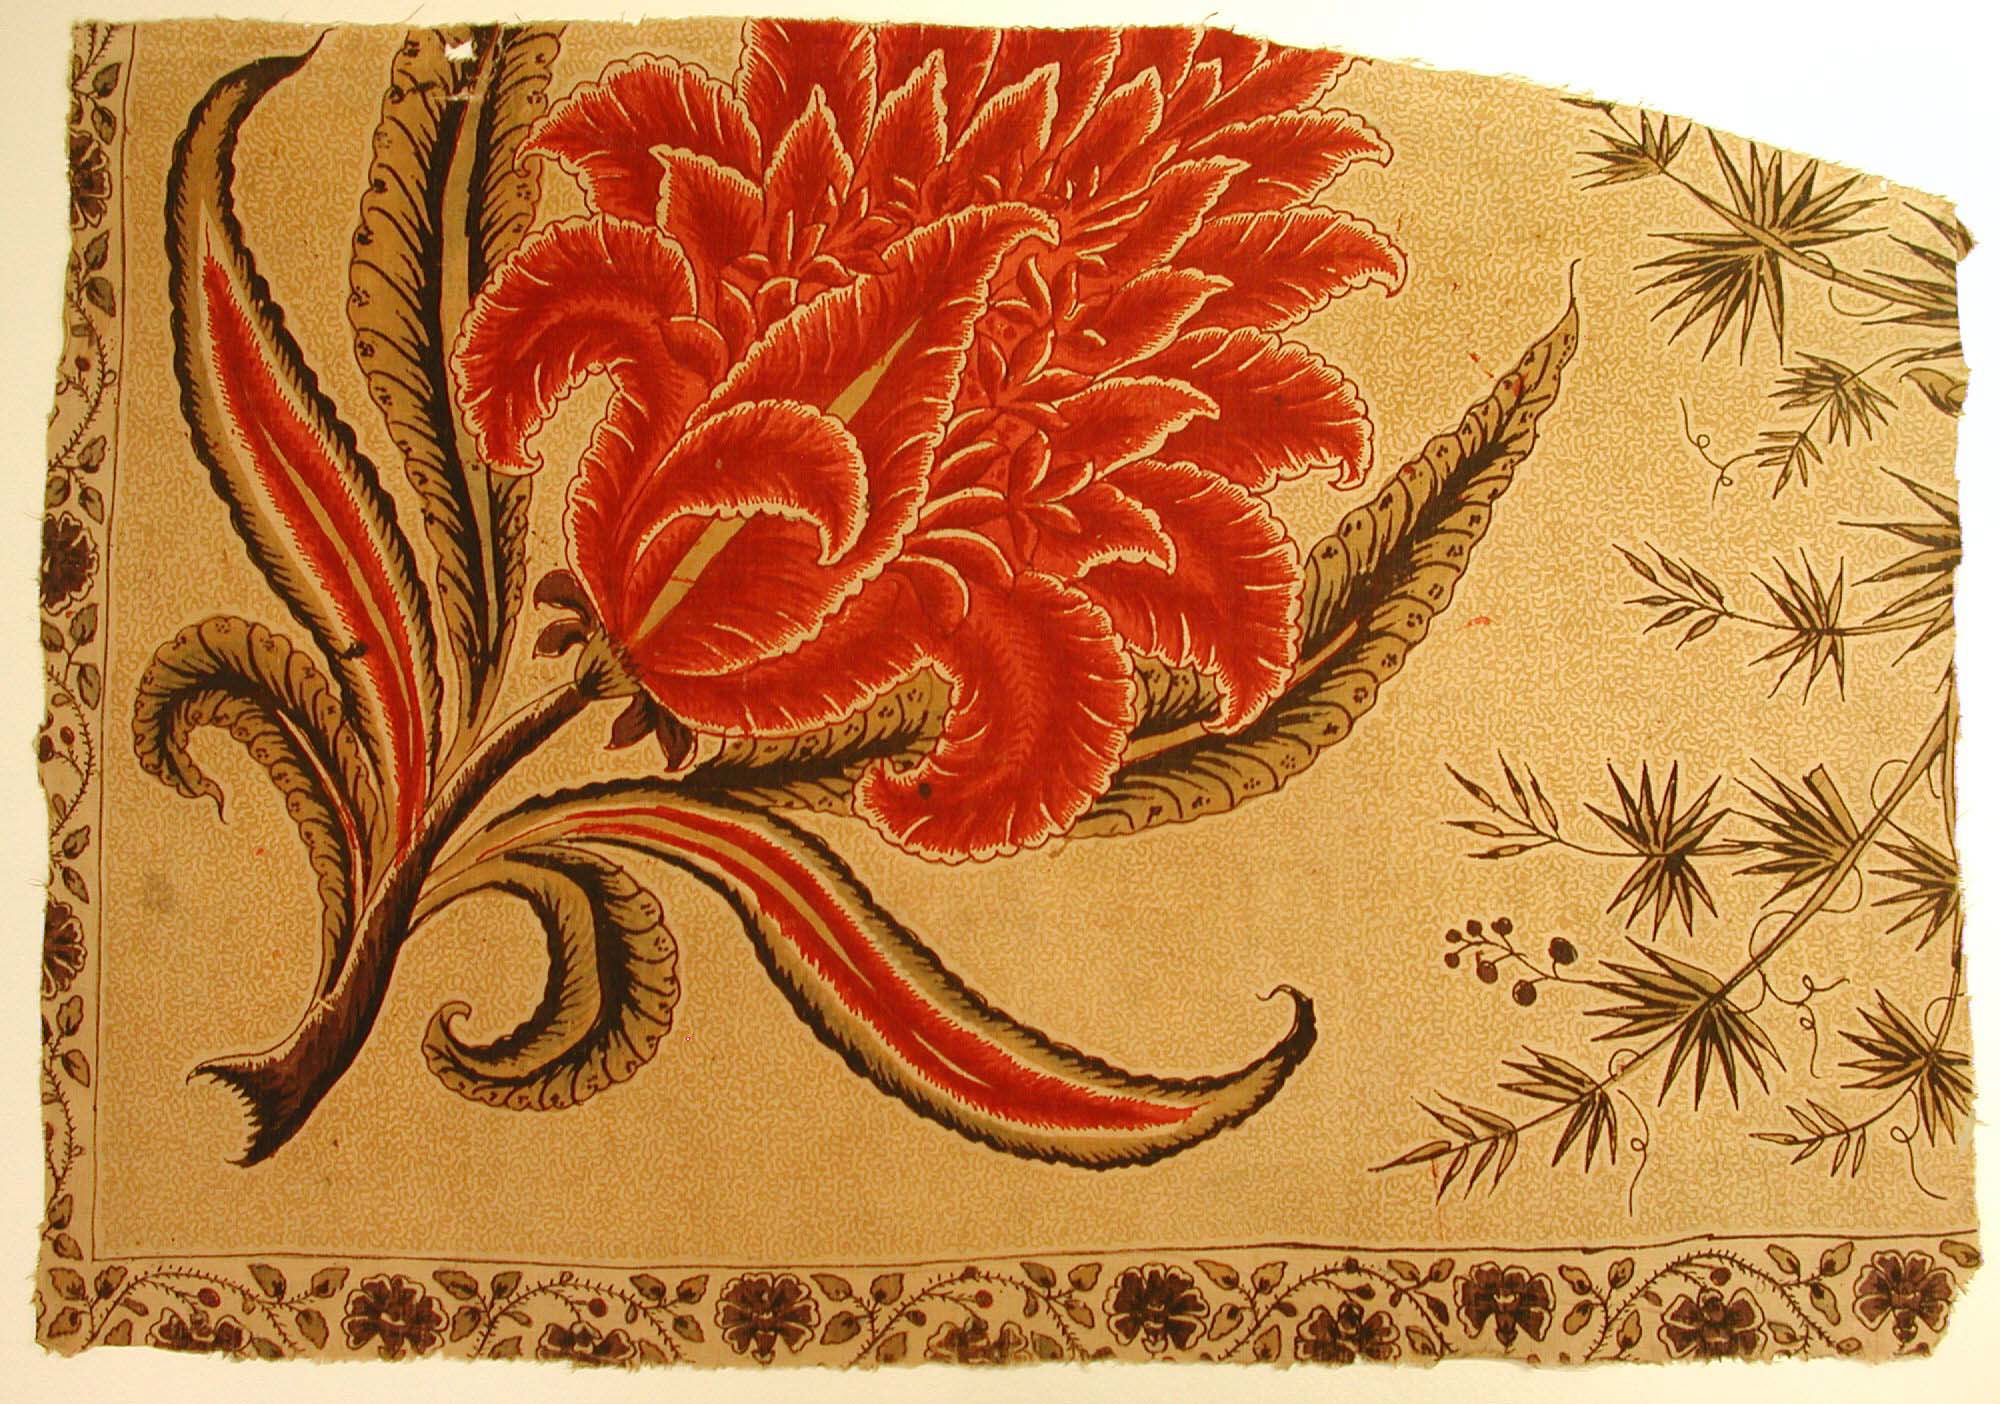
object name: fragment of a veil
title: Fragment of a Veil (Yashmak)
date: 1701-1800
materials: cotton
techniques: painting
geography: india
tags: flowers